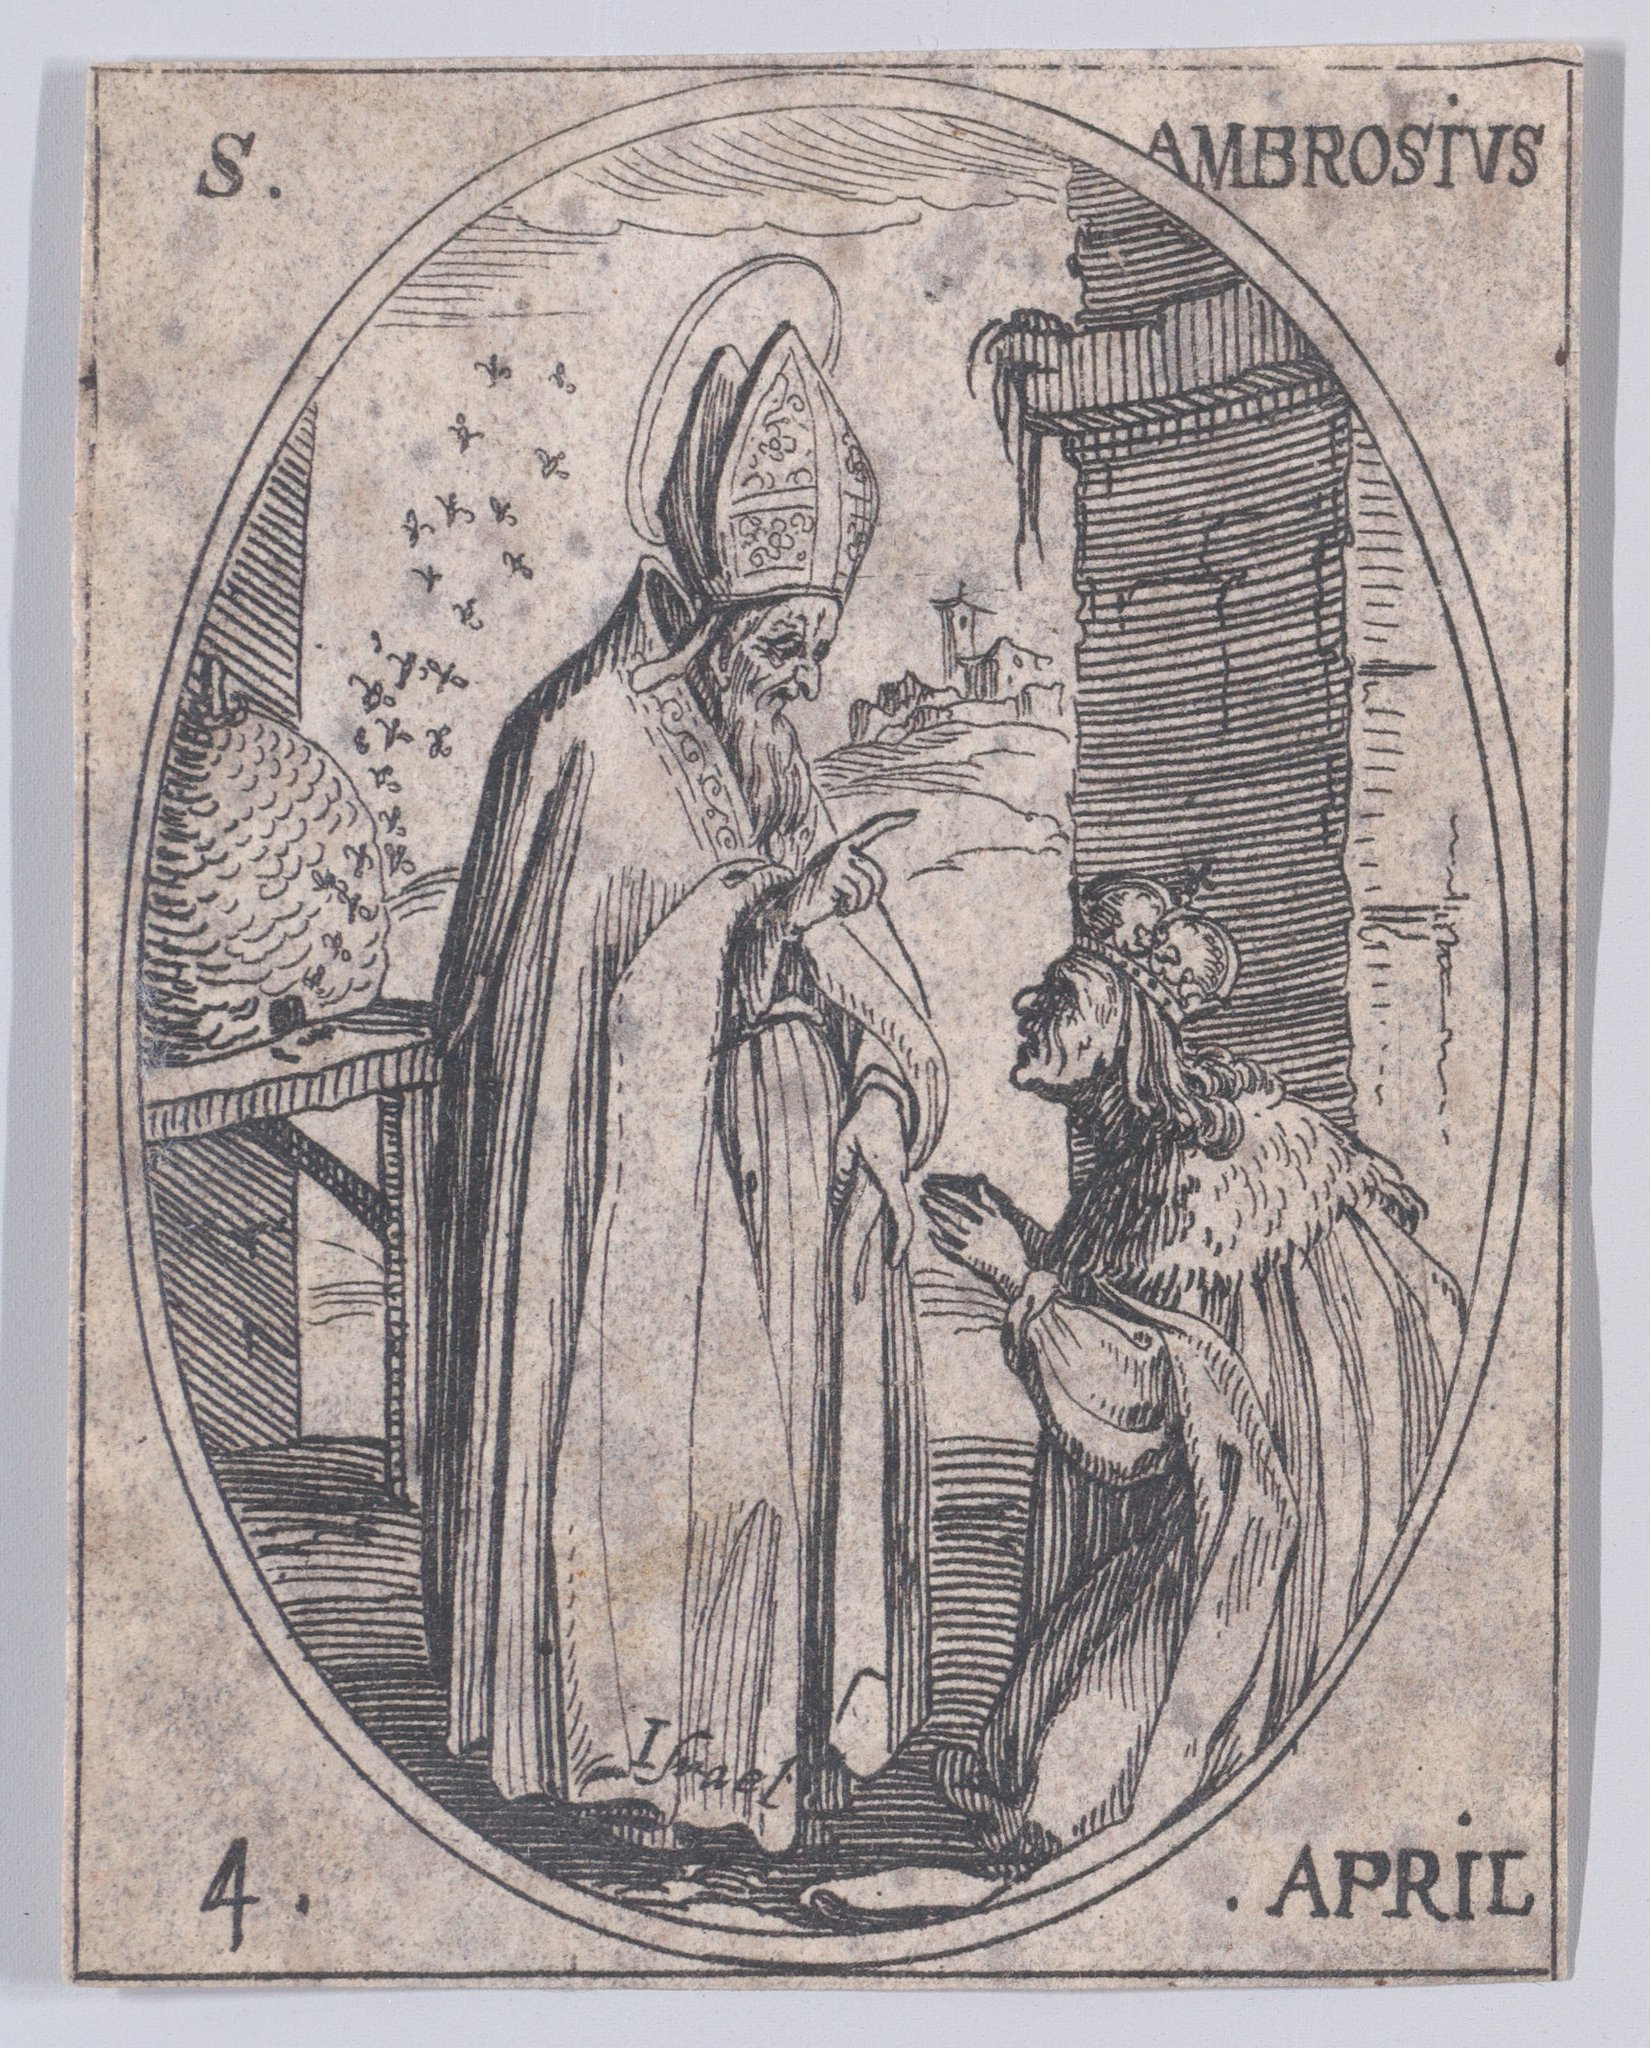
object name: print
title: S. Ambroise (St. Ambrose), April 4th, from "Les Images De Tous Les Saincts et Saintes de L'Année" (Images of All of the Saints and Religious Events of the Year)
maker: jacques callot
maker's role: artist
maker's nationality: french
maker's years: 1592-1635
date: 1636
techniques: etching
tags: men,saints